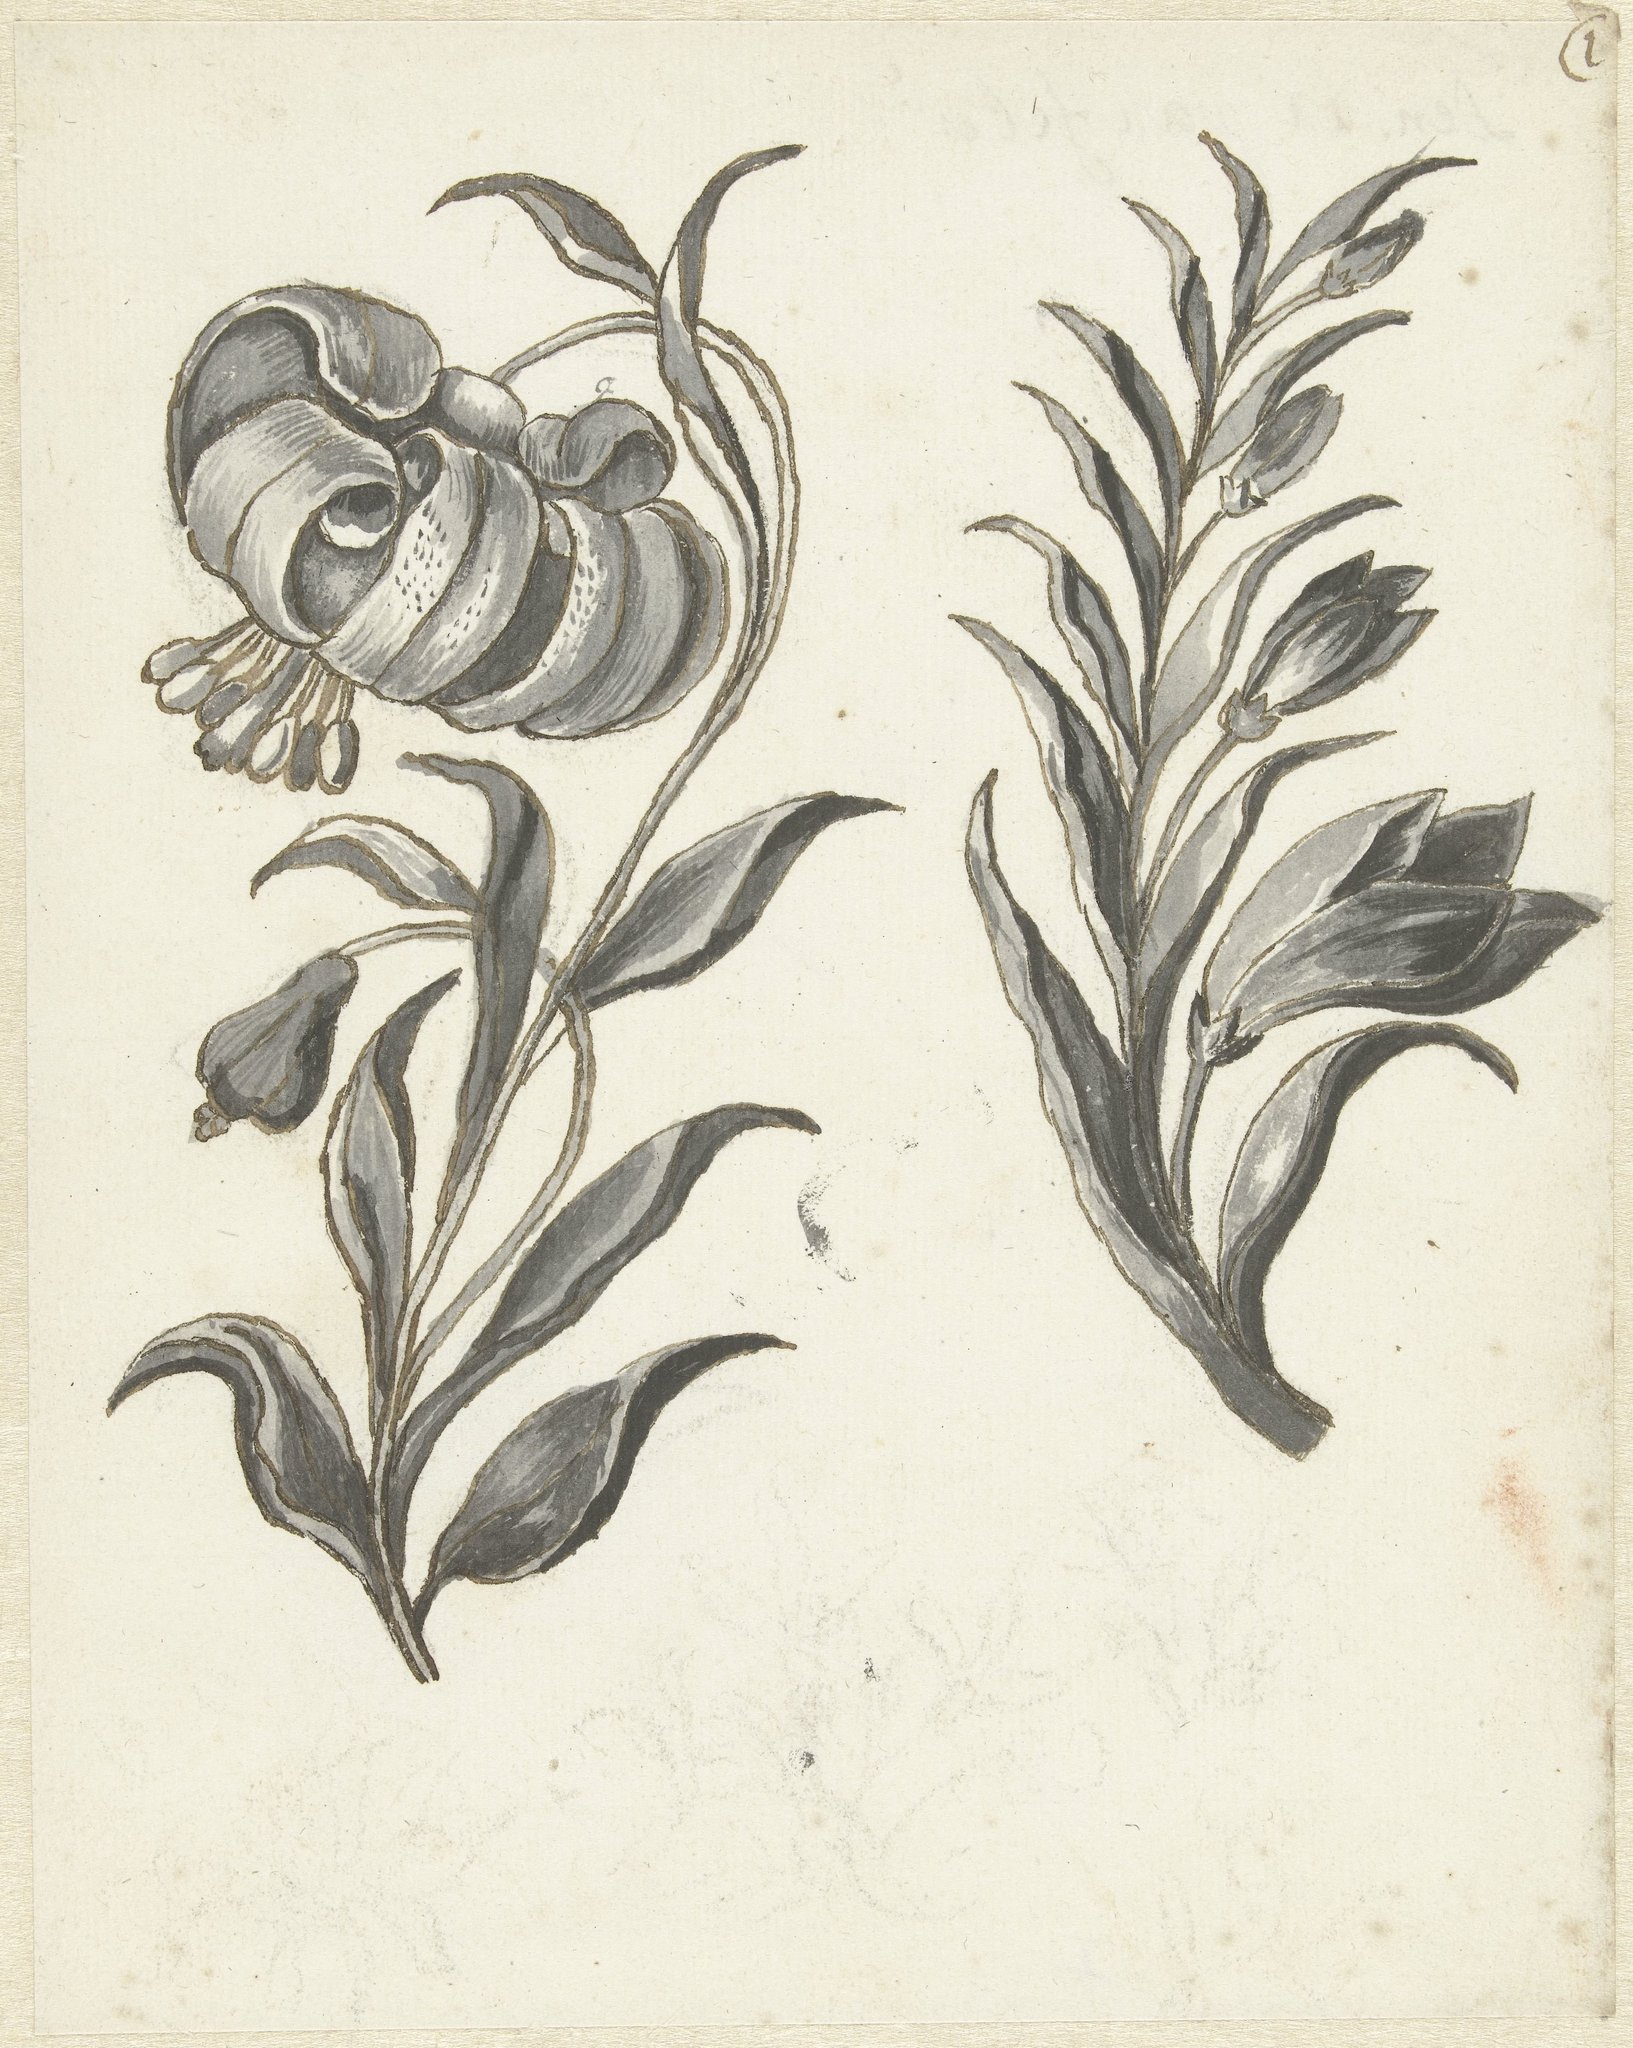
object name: drawing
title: Tijgerlelie en gemene Bolderik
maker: bernard picart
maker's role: draughtsman, print maker, publisher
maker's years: 1673-1733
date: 1683-1733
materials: chalk, ink, paper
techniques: brush, pen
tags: flowers: cockle, flowers: lily